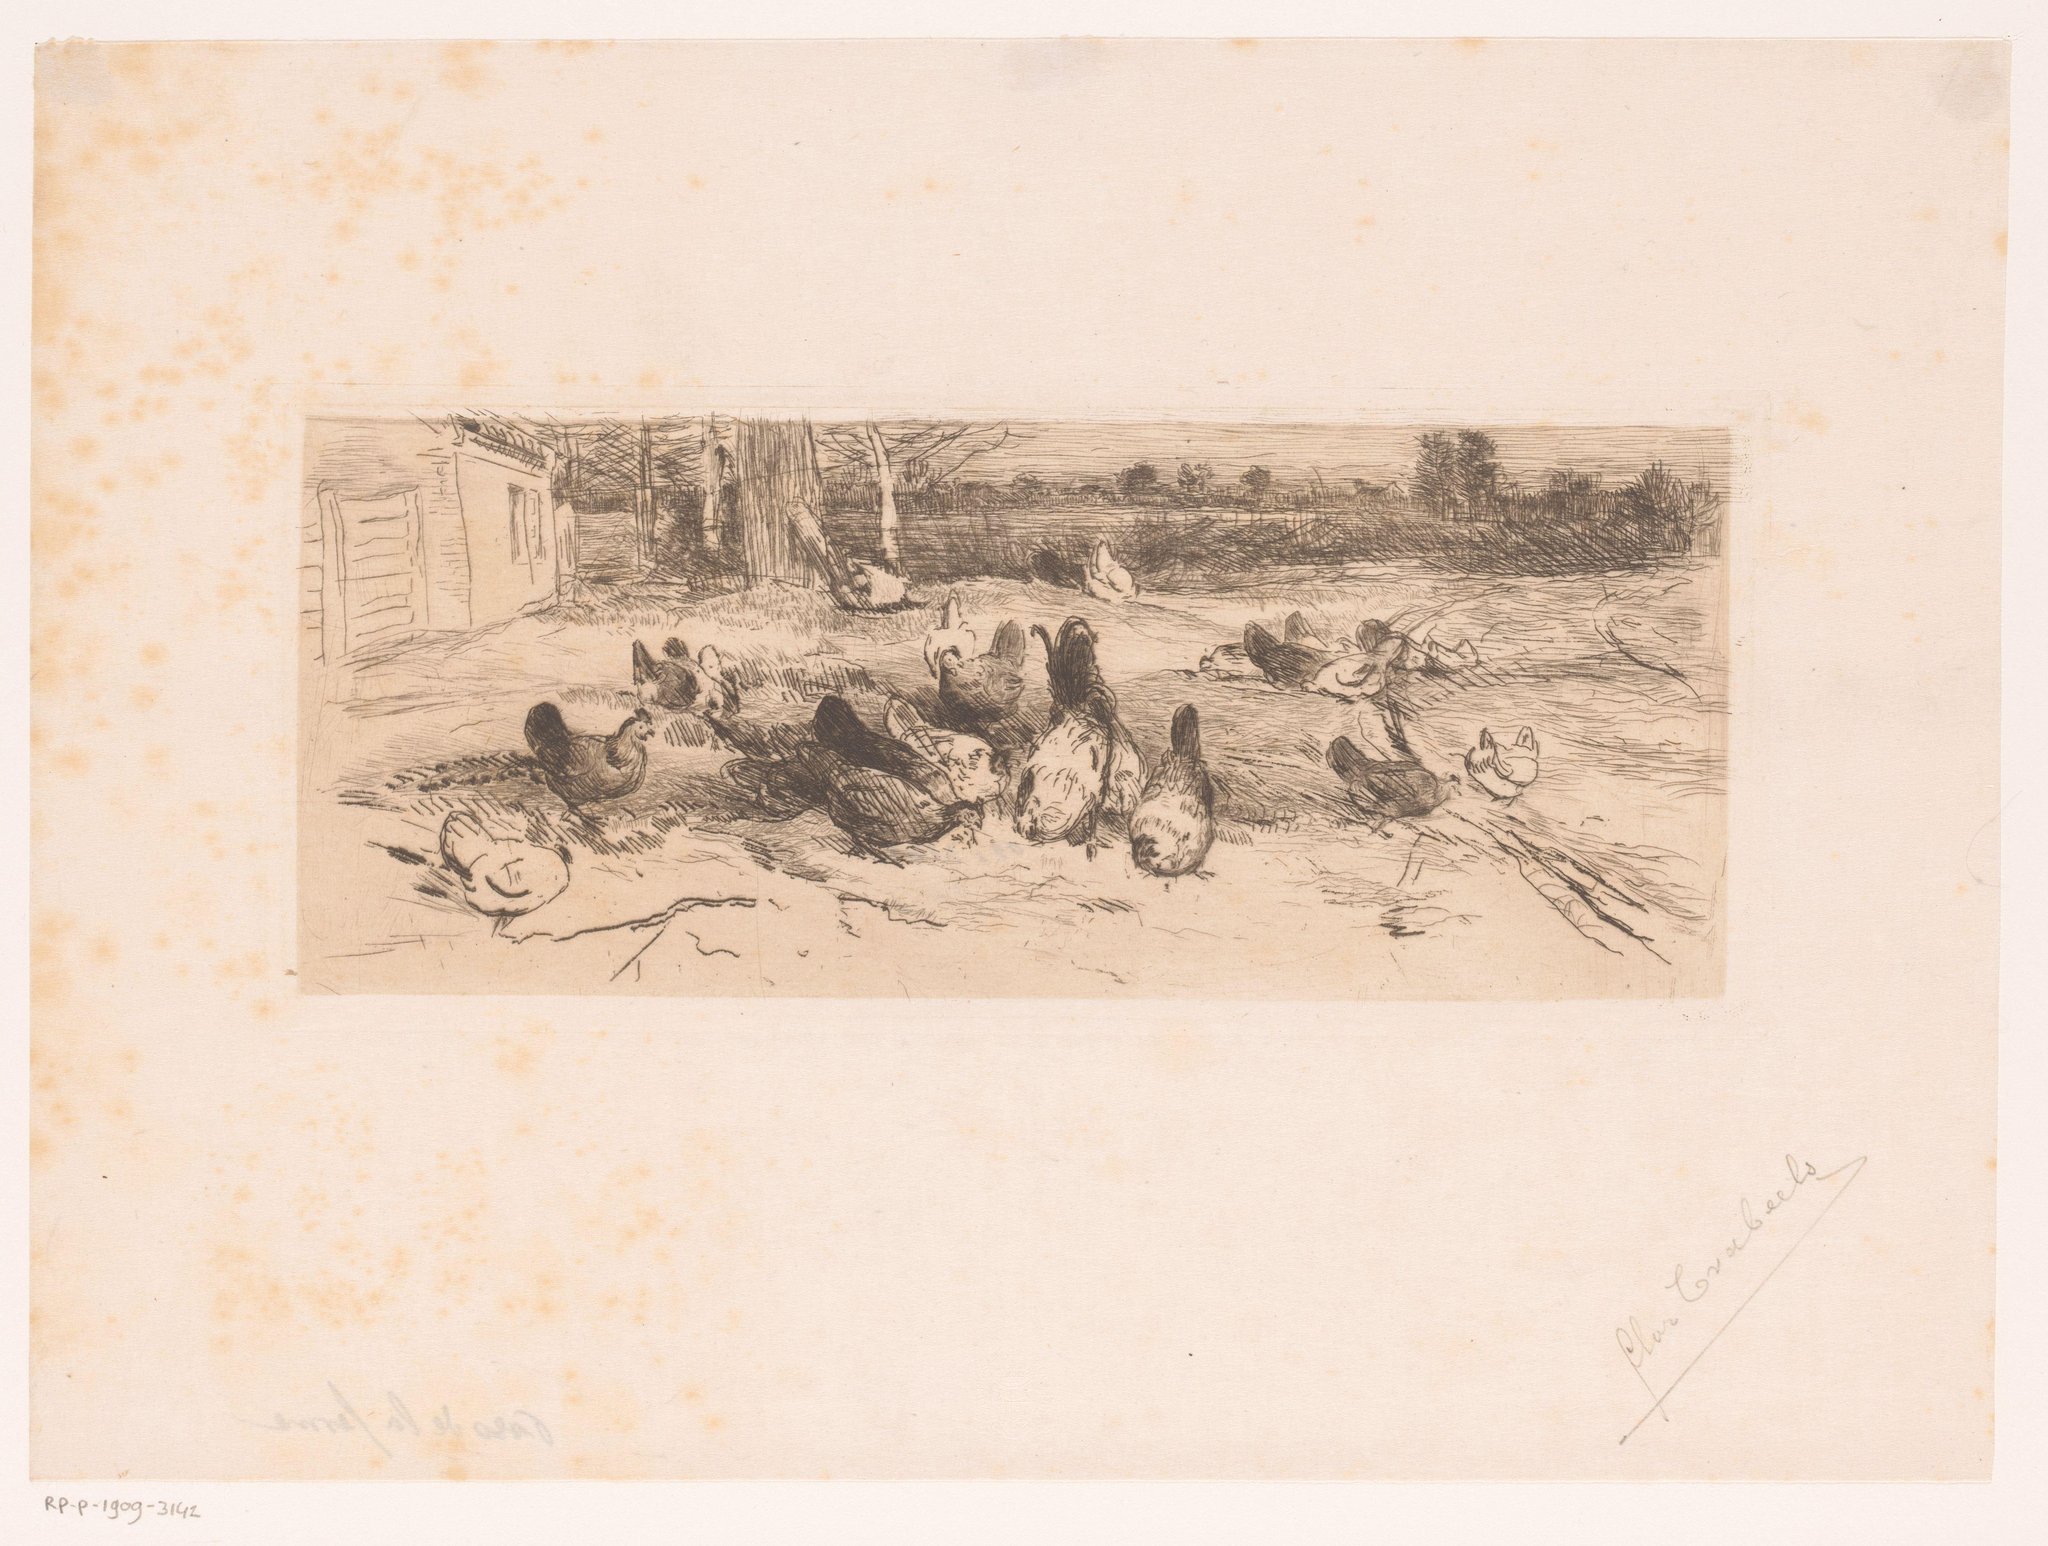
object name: print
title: Kippen in het gras langs een weg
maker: florent nicolas crabeels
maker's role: print maker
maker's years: 1829-1896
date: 1839-1896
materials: paper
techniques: drypoint, etching, intaglio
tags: fowl (cock, hen, chicken, etc.)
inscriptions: collector's mark: Lugt 2228, mark: ‘Antwerpsche Etsers 1880’